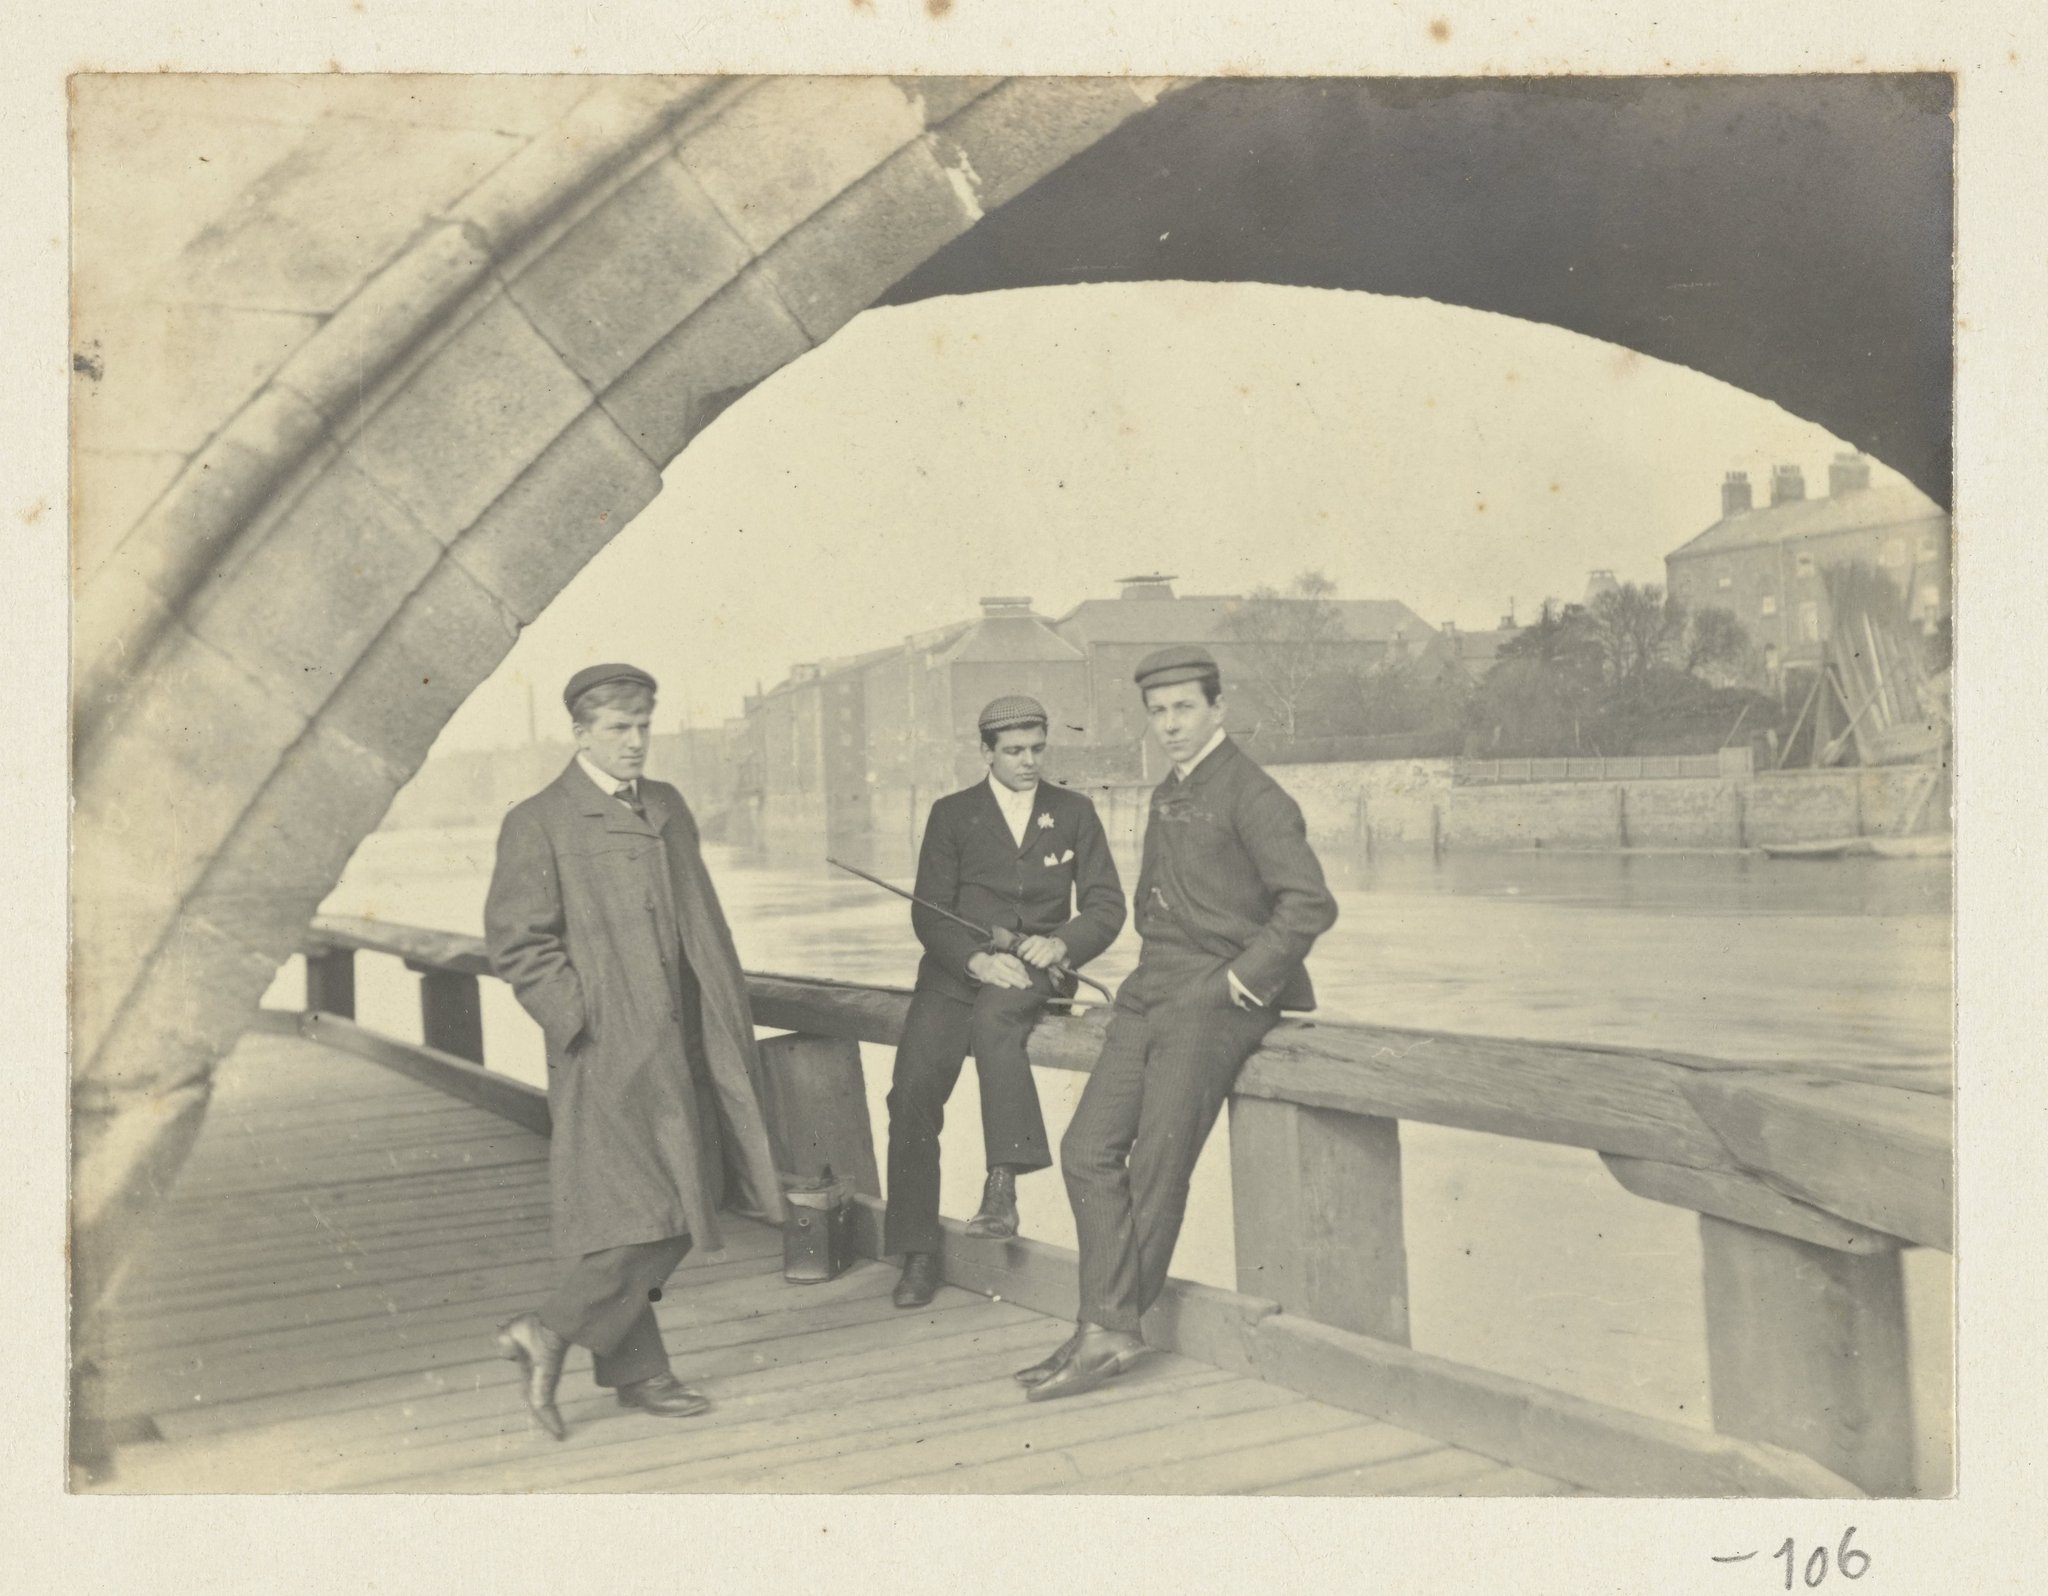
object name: photograph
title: De vrienden van Dolph Kessler poseren onder Gainsborough Bridge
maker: geldolph adriaan kessler (dolph)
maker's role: fotograaf, industrieel, voetballer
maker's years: 1884-1945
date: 1903-1904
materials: cardboard, photographic support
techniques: gelatin silver print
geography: gainsborough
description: Dolph Kessler (rechts) en twee vrienden poseren onder Gainsborough Bridge, op de achtergrond de rivier de Trent. Onderdeel van het fotoalbum van Dolph Kessler met opnamen die hij maakte tijdens zijn verblijf in Engeland en op een wereldreis die hij als secretaris van Henri Deterding (directeur Koninklijke Olie) ondernam naar Nederlands-Indië, Japan, China en de Verenigde Staten, tussen 1906 en 1908.